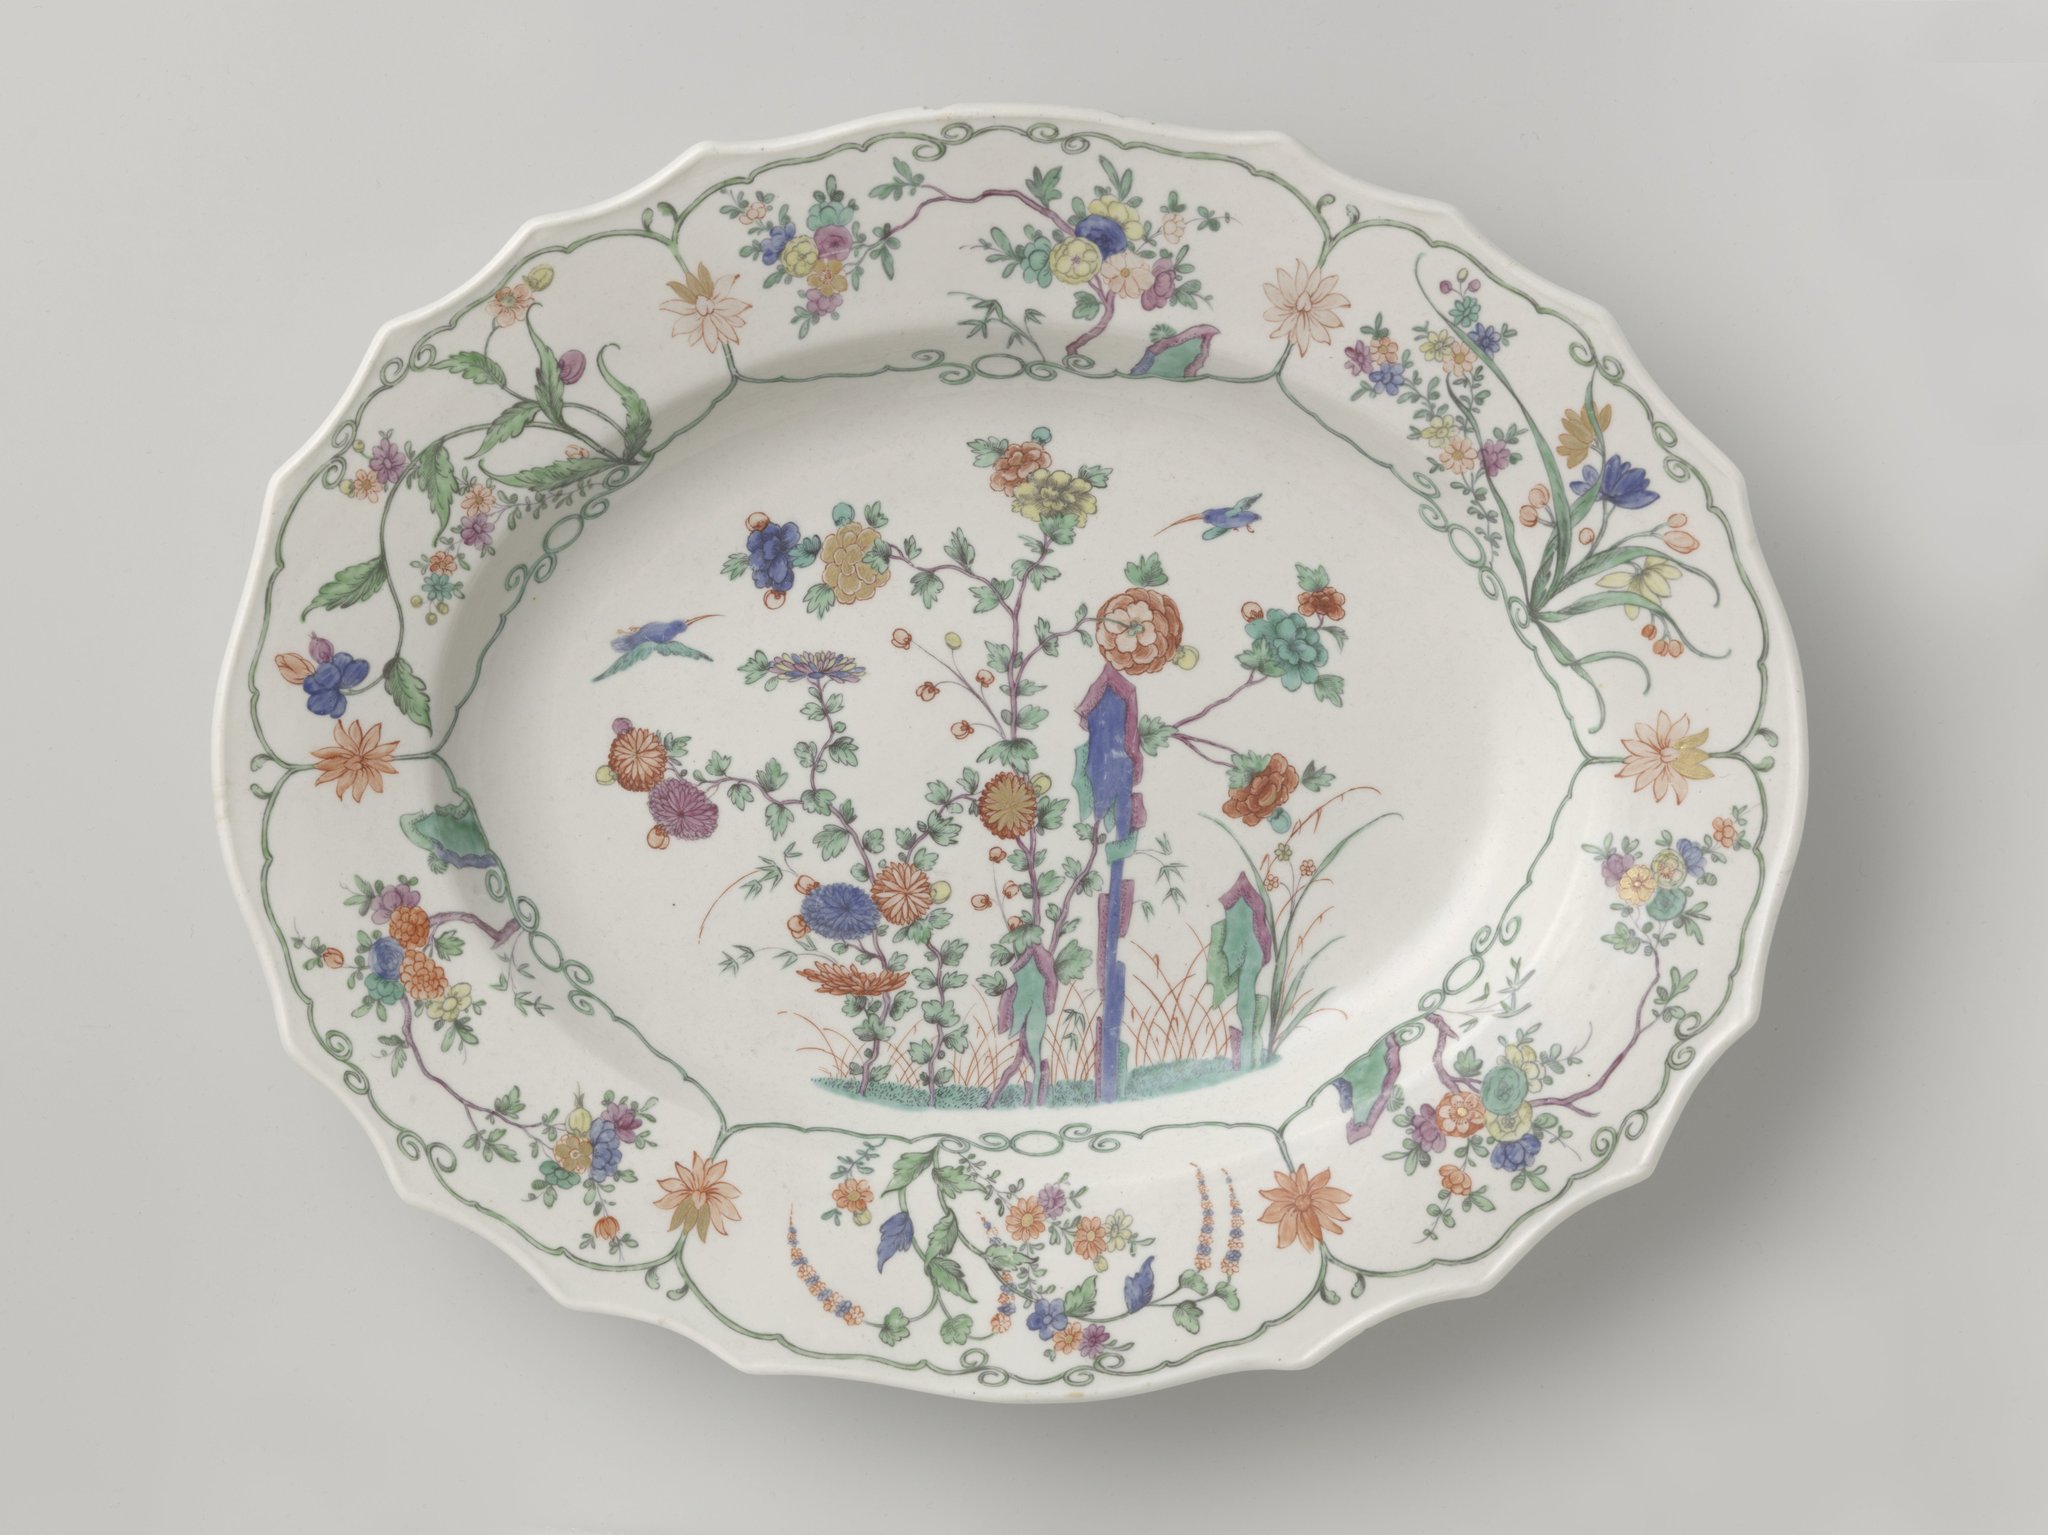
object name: platter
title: Schotel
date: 1777-1790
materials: porcelain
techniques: painted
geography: doornik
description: Dish. Soft-paste porcelain. Tournai, decorated in The Hague, c. 1777 - 1790. Factory of Anton Lyncker or his heirs.